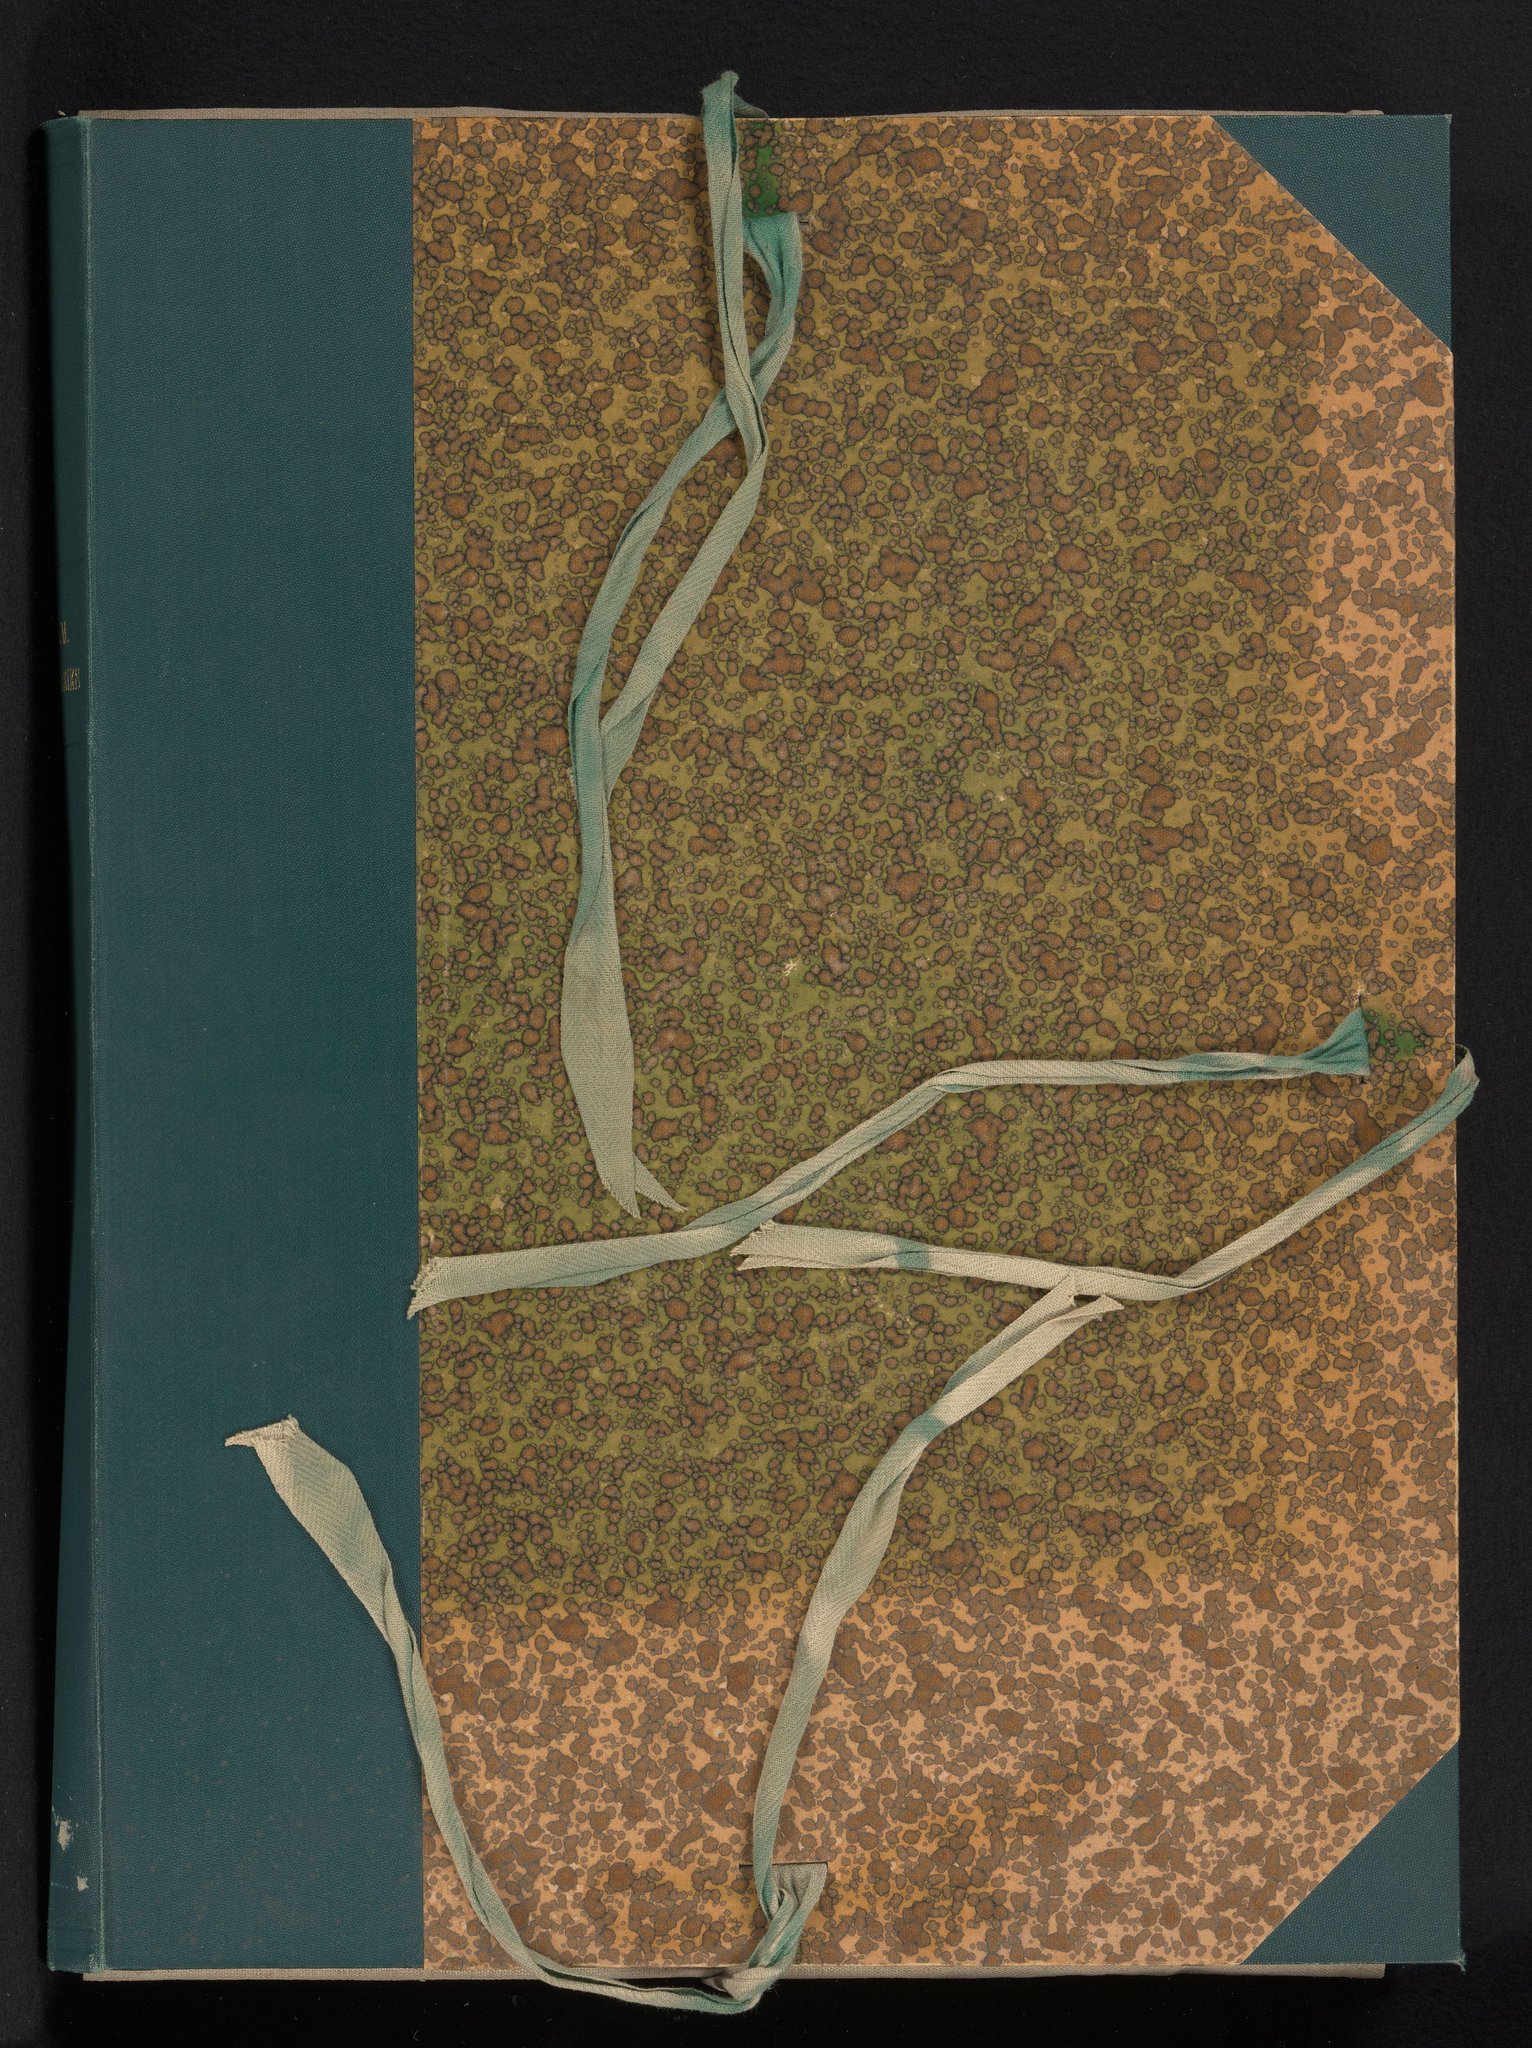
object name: folder container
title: J.L.M. Lauweriks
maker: mathieu lauweriks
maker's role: designer, draughtsman, print maker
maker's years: 1864-1932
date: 1898-1918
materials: cardboard, linen, paper, fiber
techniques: marbled paper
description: Map voor 22 foto's van ontwerpen en tekeningen door Mathieu Lauweriks en enige documentatie, waaronder een nummer van de Neudeutsche Bauzeitung van 9 juli 1914 , twee losse bladen uit de Deutsche Goldsmiede-Zeitung uit 1913 en het jaarverslag van 1918 van de kunstnijverheidsschool Quellinus uit Amsterdam.